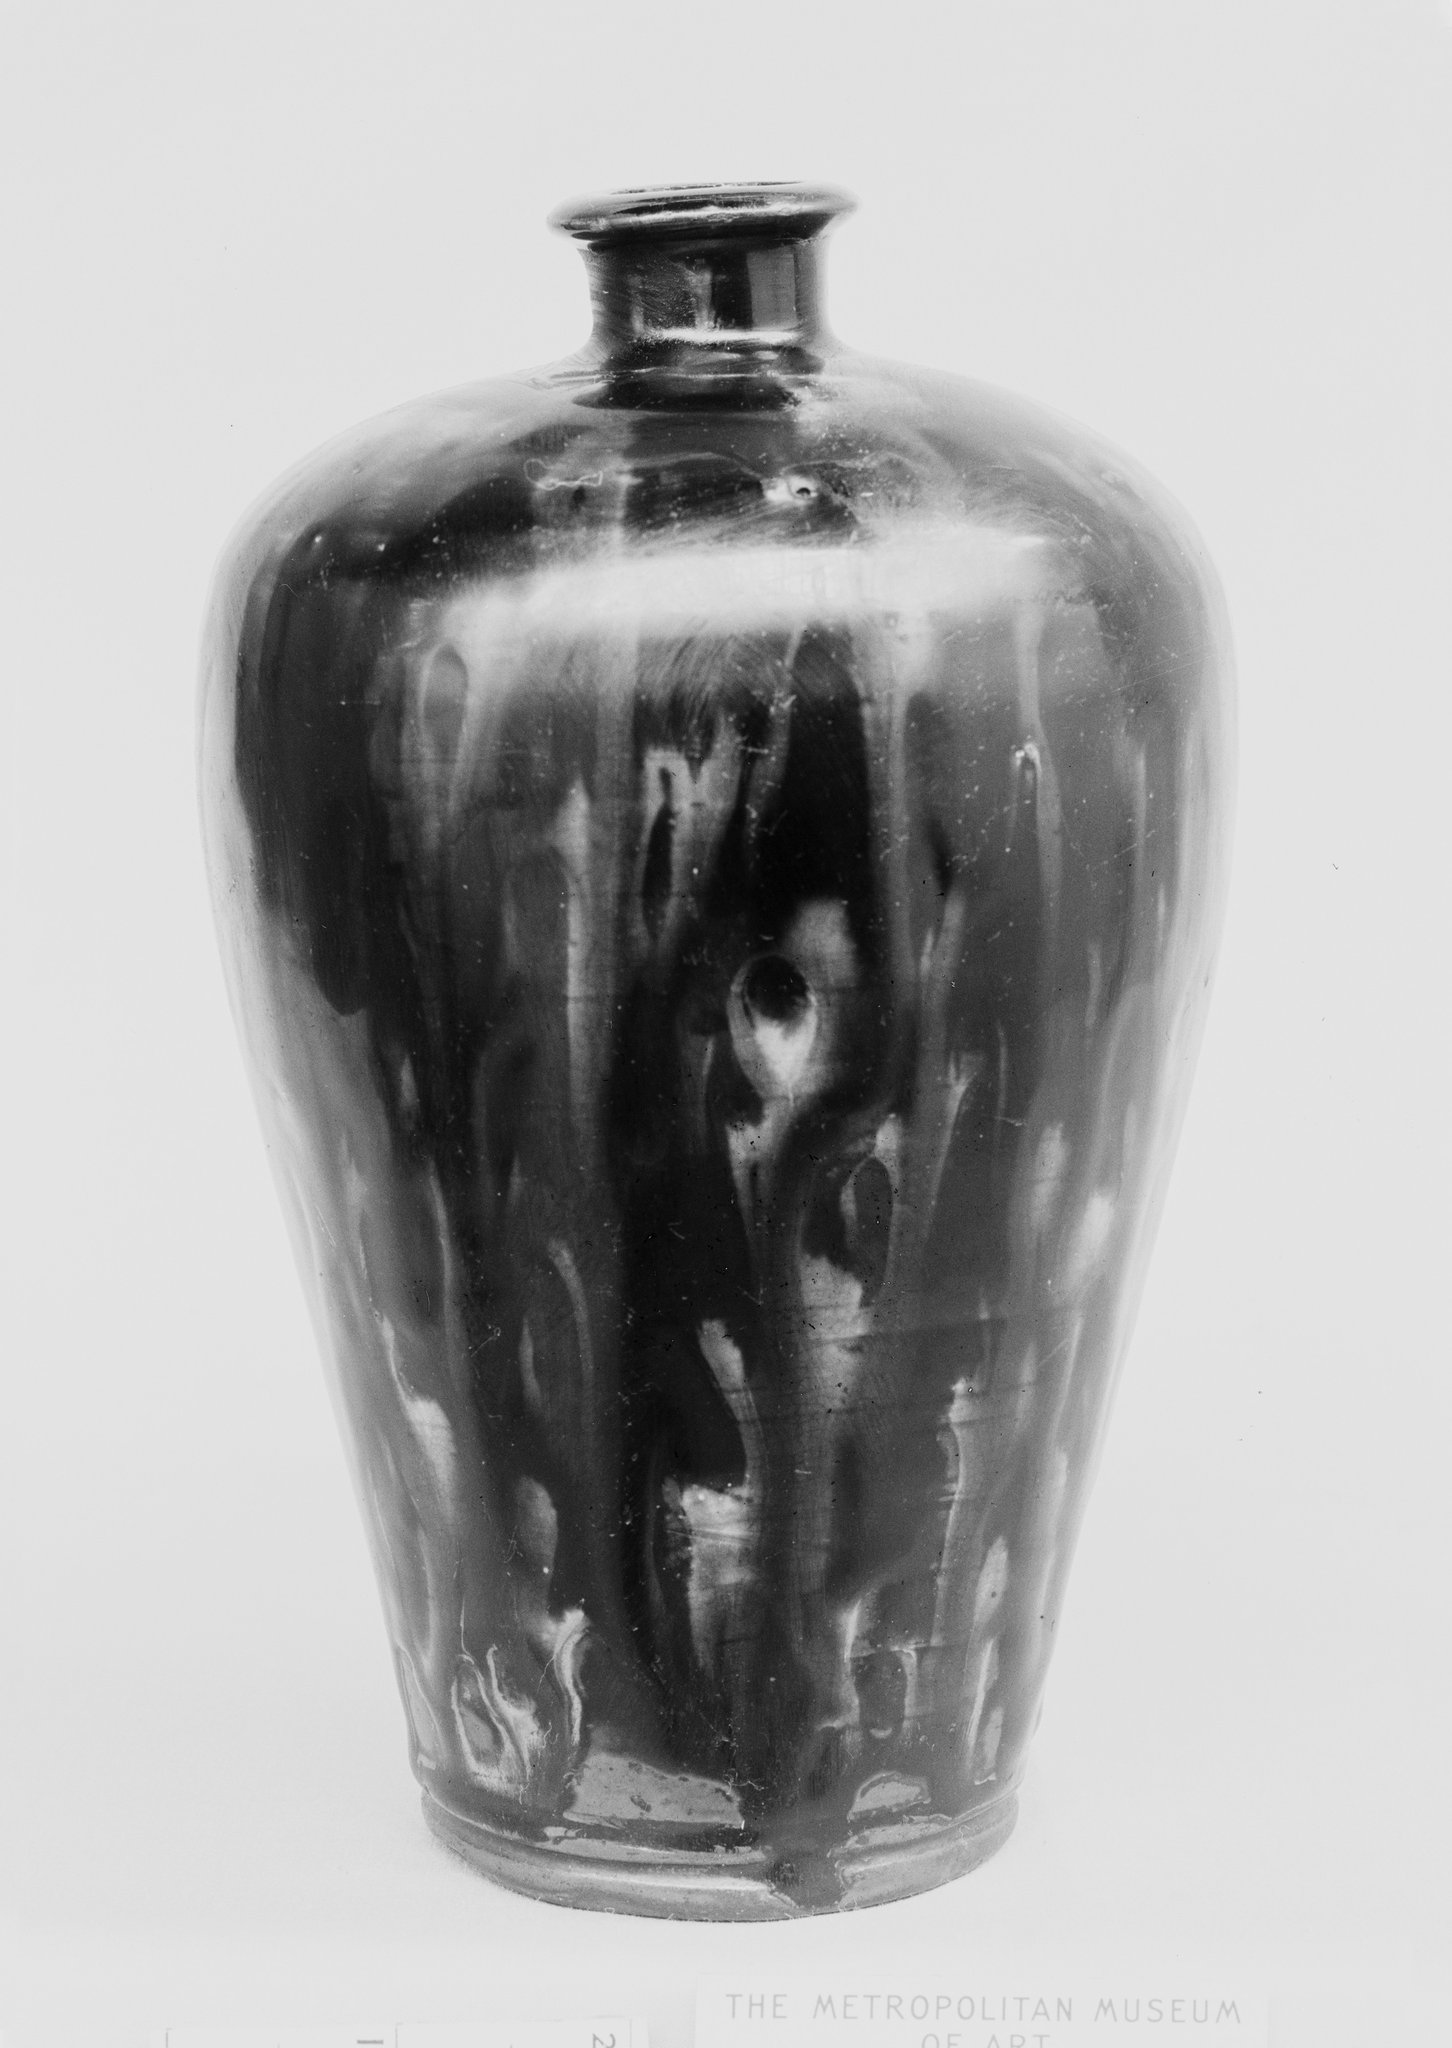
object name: bottle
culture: japanese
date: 1701-1800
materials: clay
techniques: overglaze